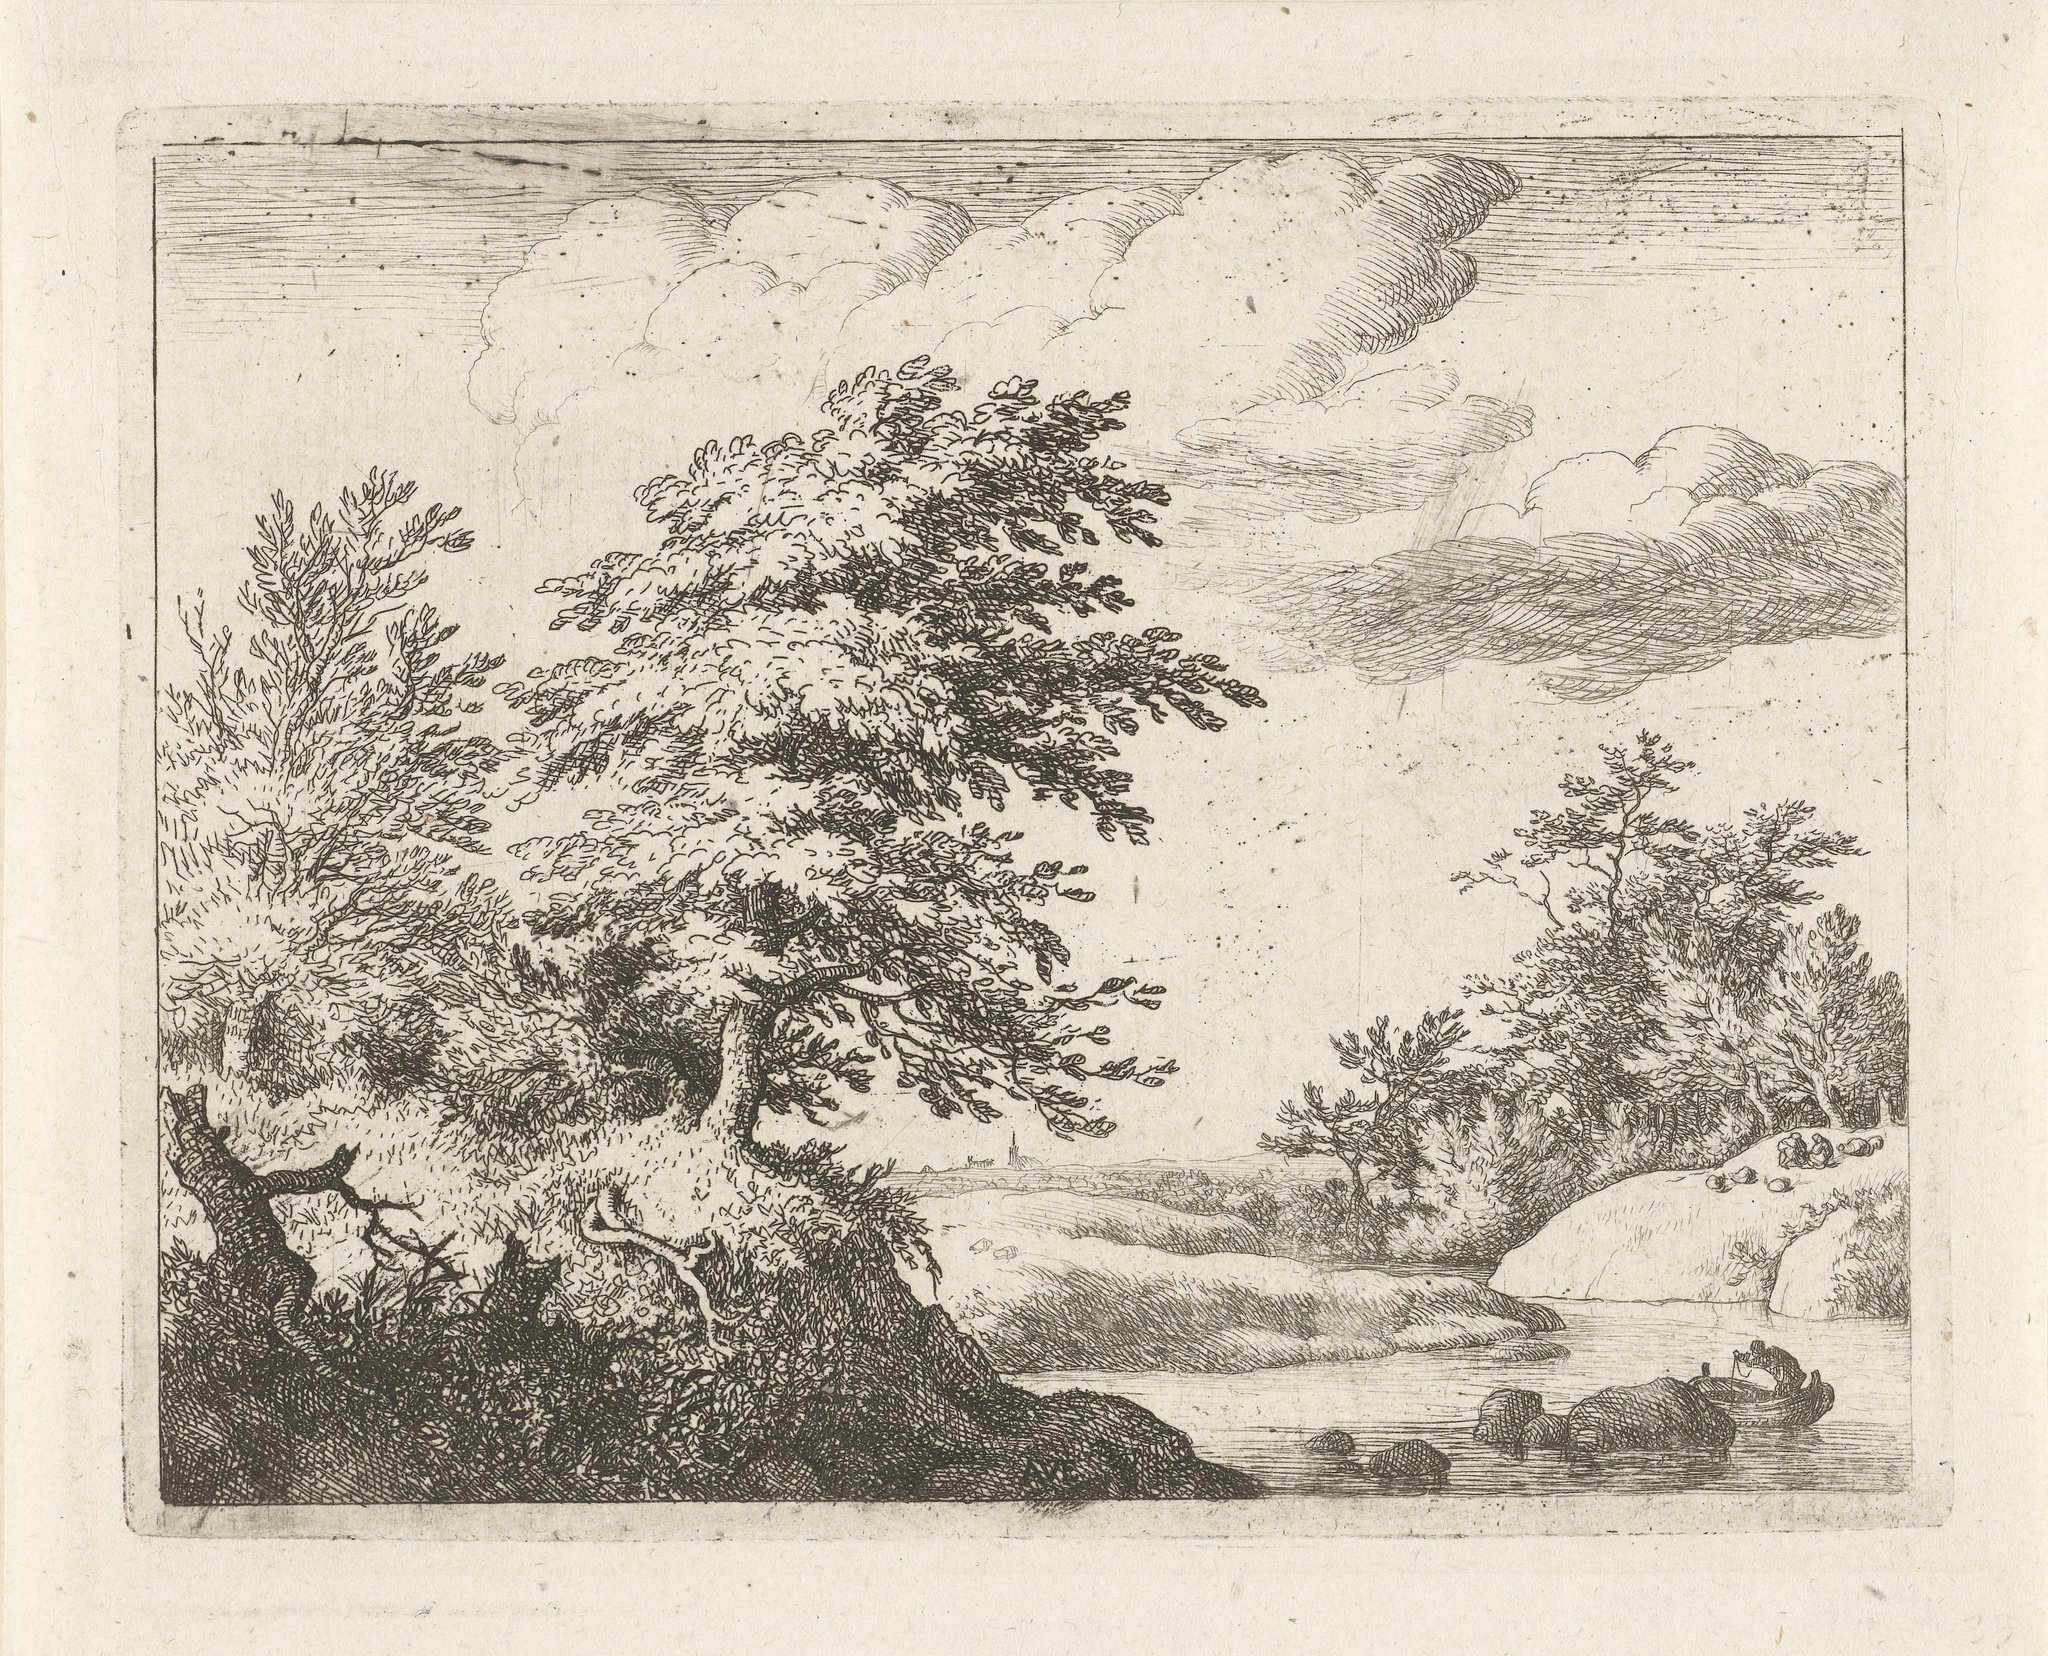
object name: print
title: Een slingerende rivier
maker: allaert van everdingen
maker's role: draughtsman, painter, print maker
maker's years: 1621-1675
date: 1631-1675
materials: paper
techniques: etching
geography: netherlands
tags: river (+ landscape with figures, staffage)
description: Gezicht op een slingerende rivier met een visser in een roeiboot. Op de oever grote bomen en aan de horizon een kerktoren.